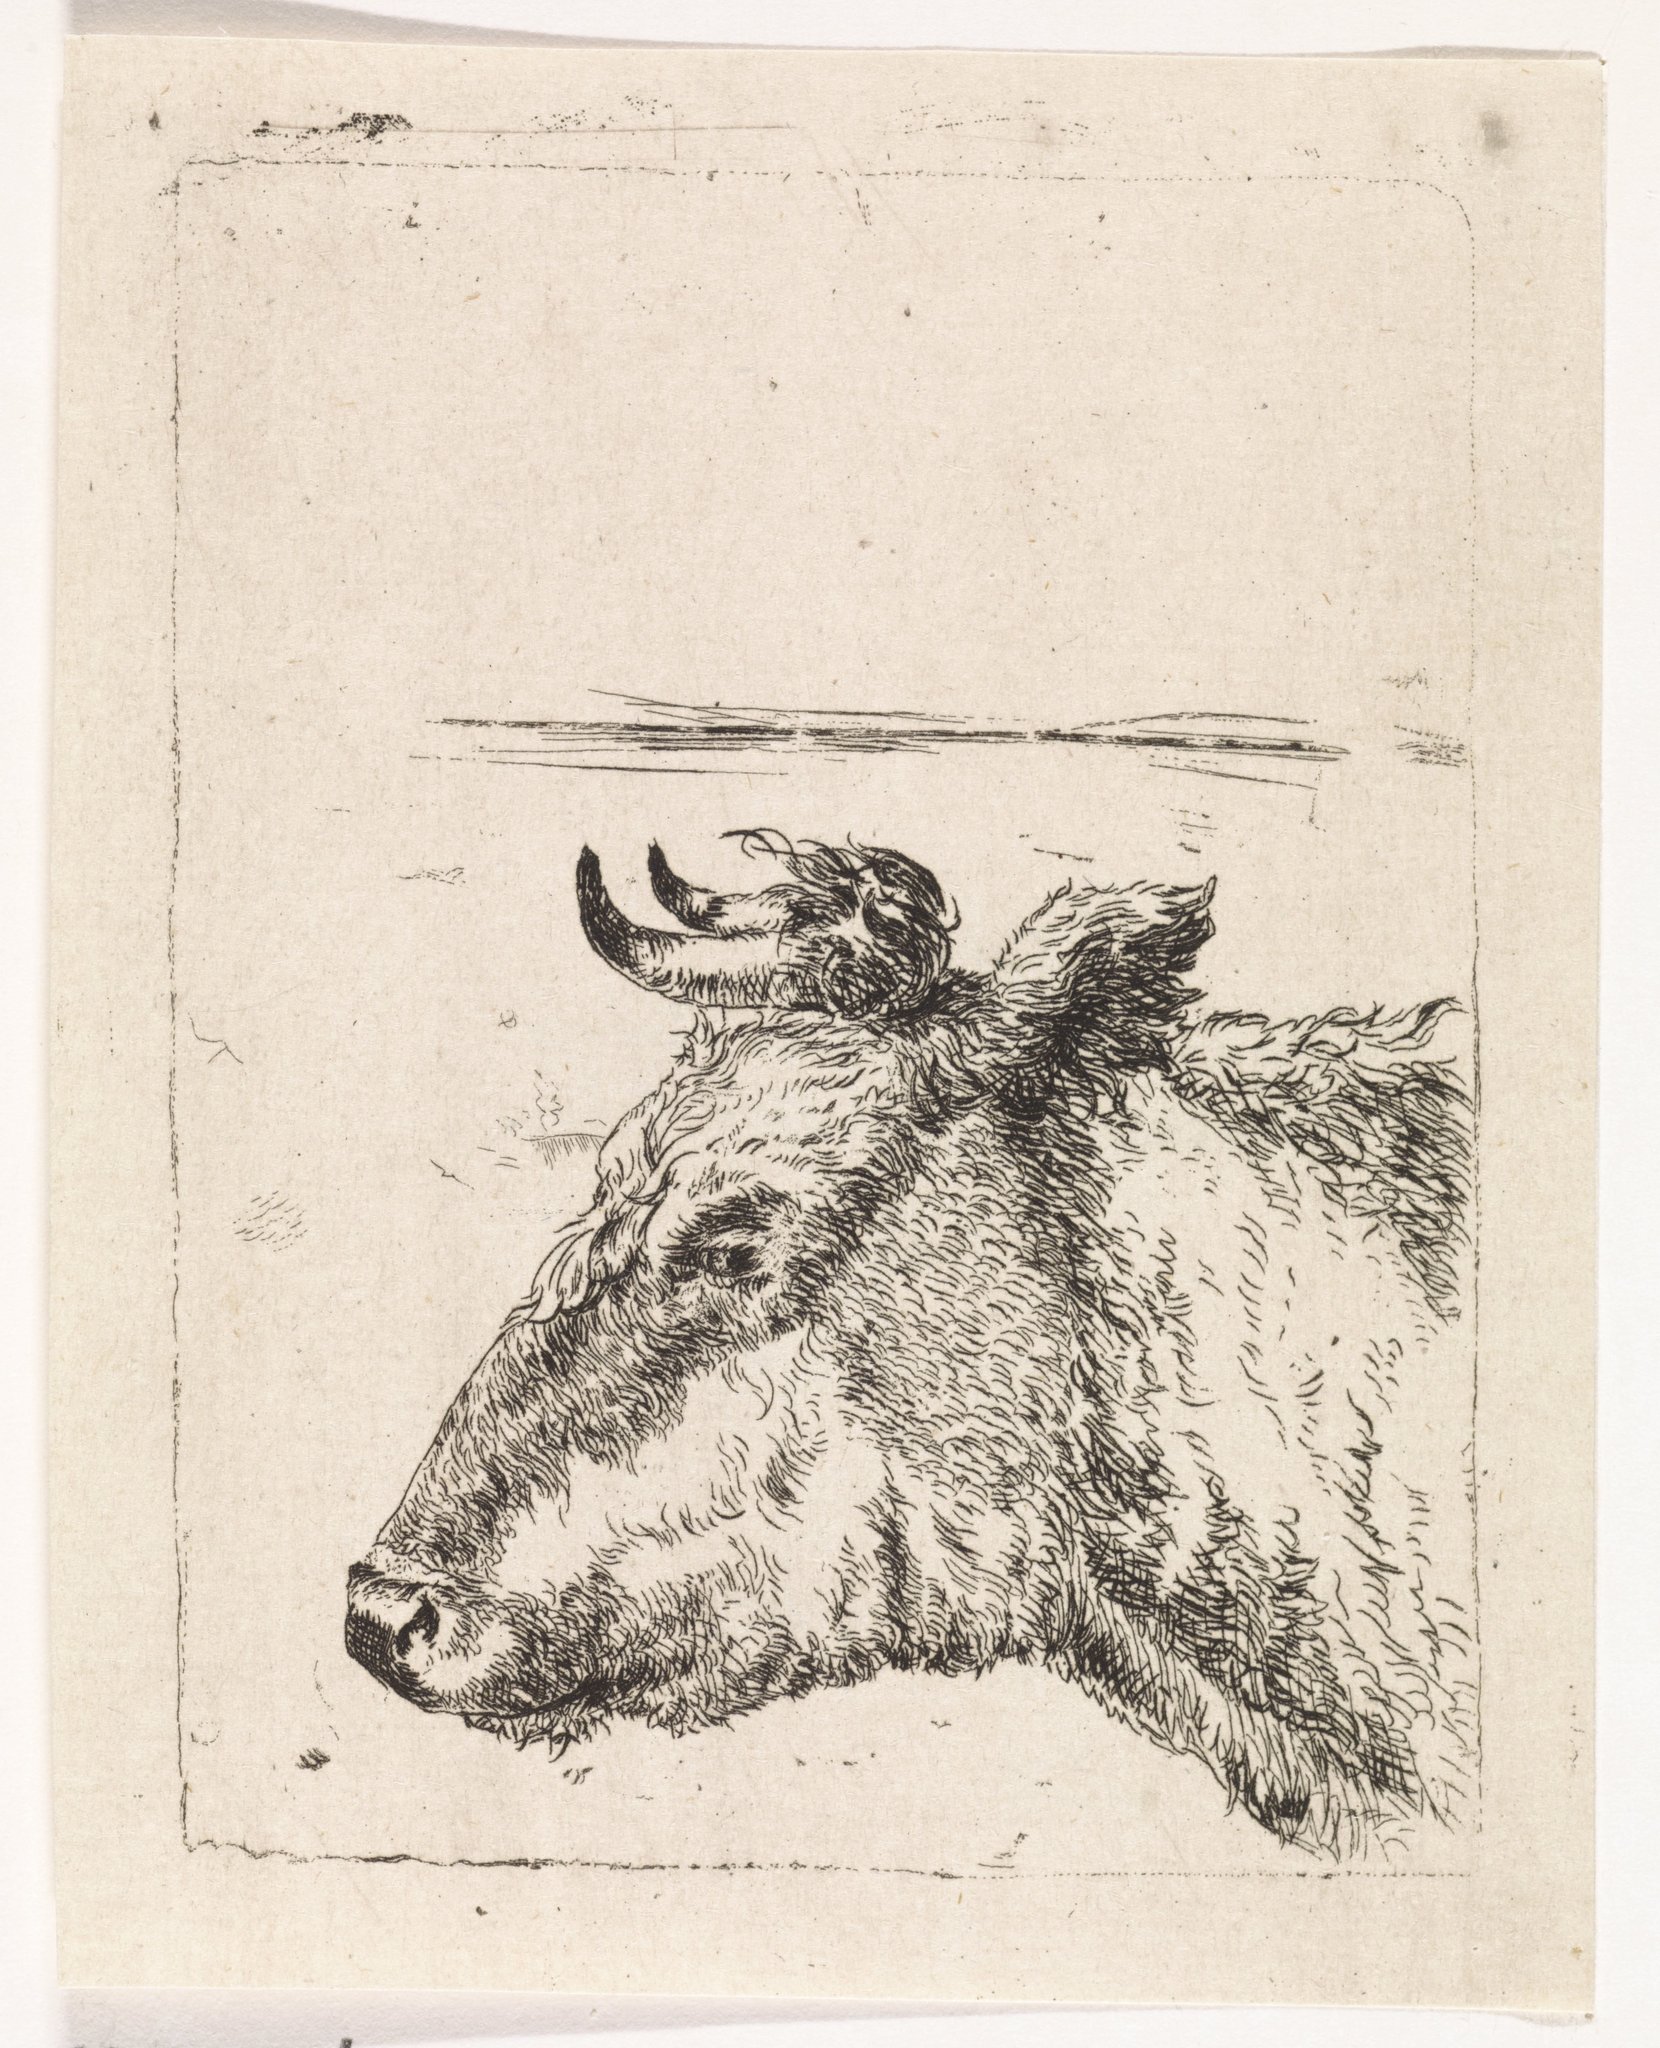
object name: print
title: Kop van een koe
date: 1830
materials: paper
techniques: etching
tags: cow, animals (+ head of an animal)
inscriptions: signature: ‘Copy Etchd in the Musée Royale Amsterdam by B.P. Gibbon July 7.1830 P.P.’, collector's mark: Lugt 2228